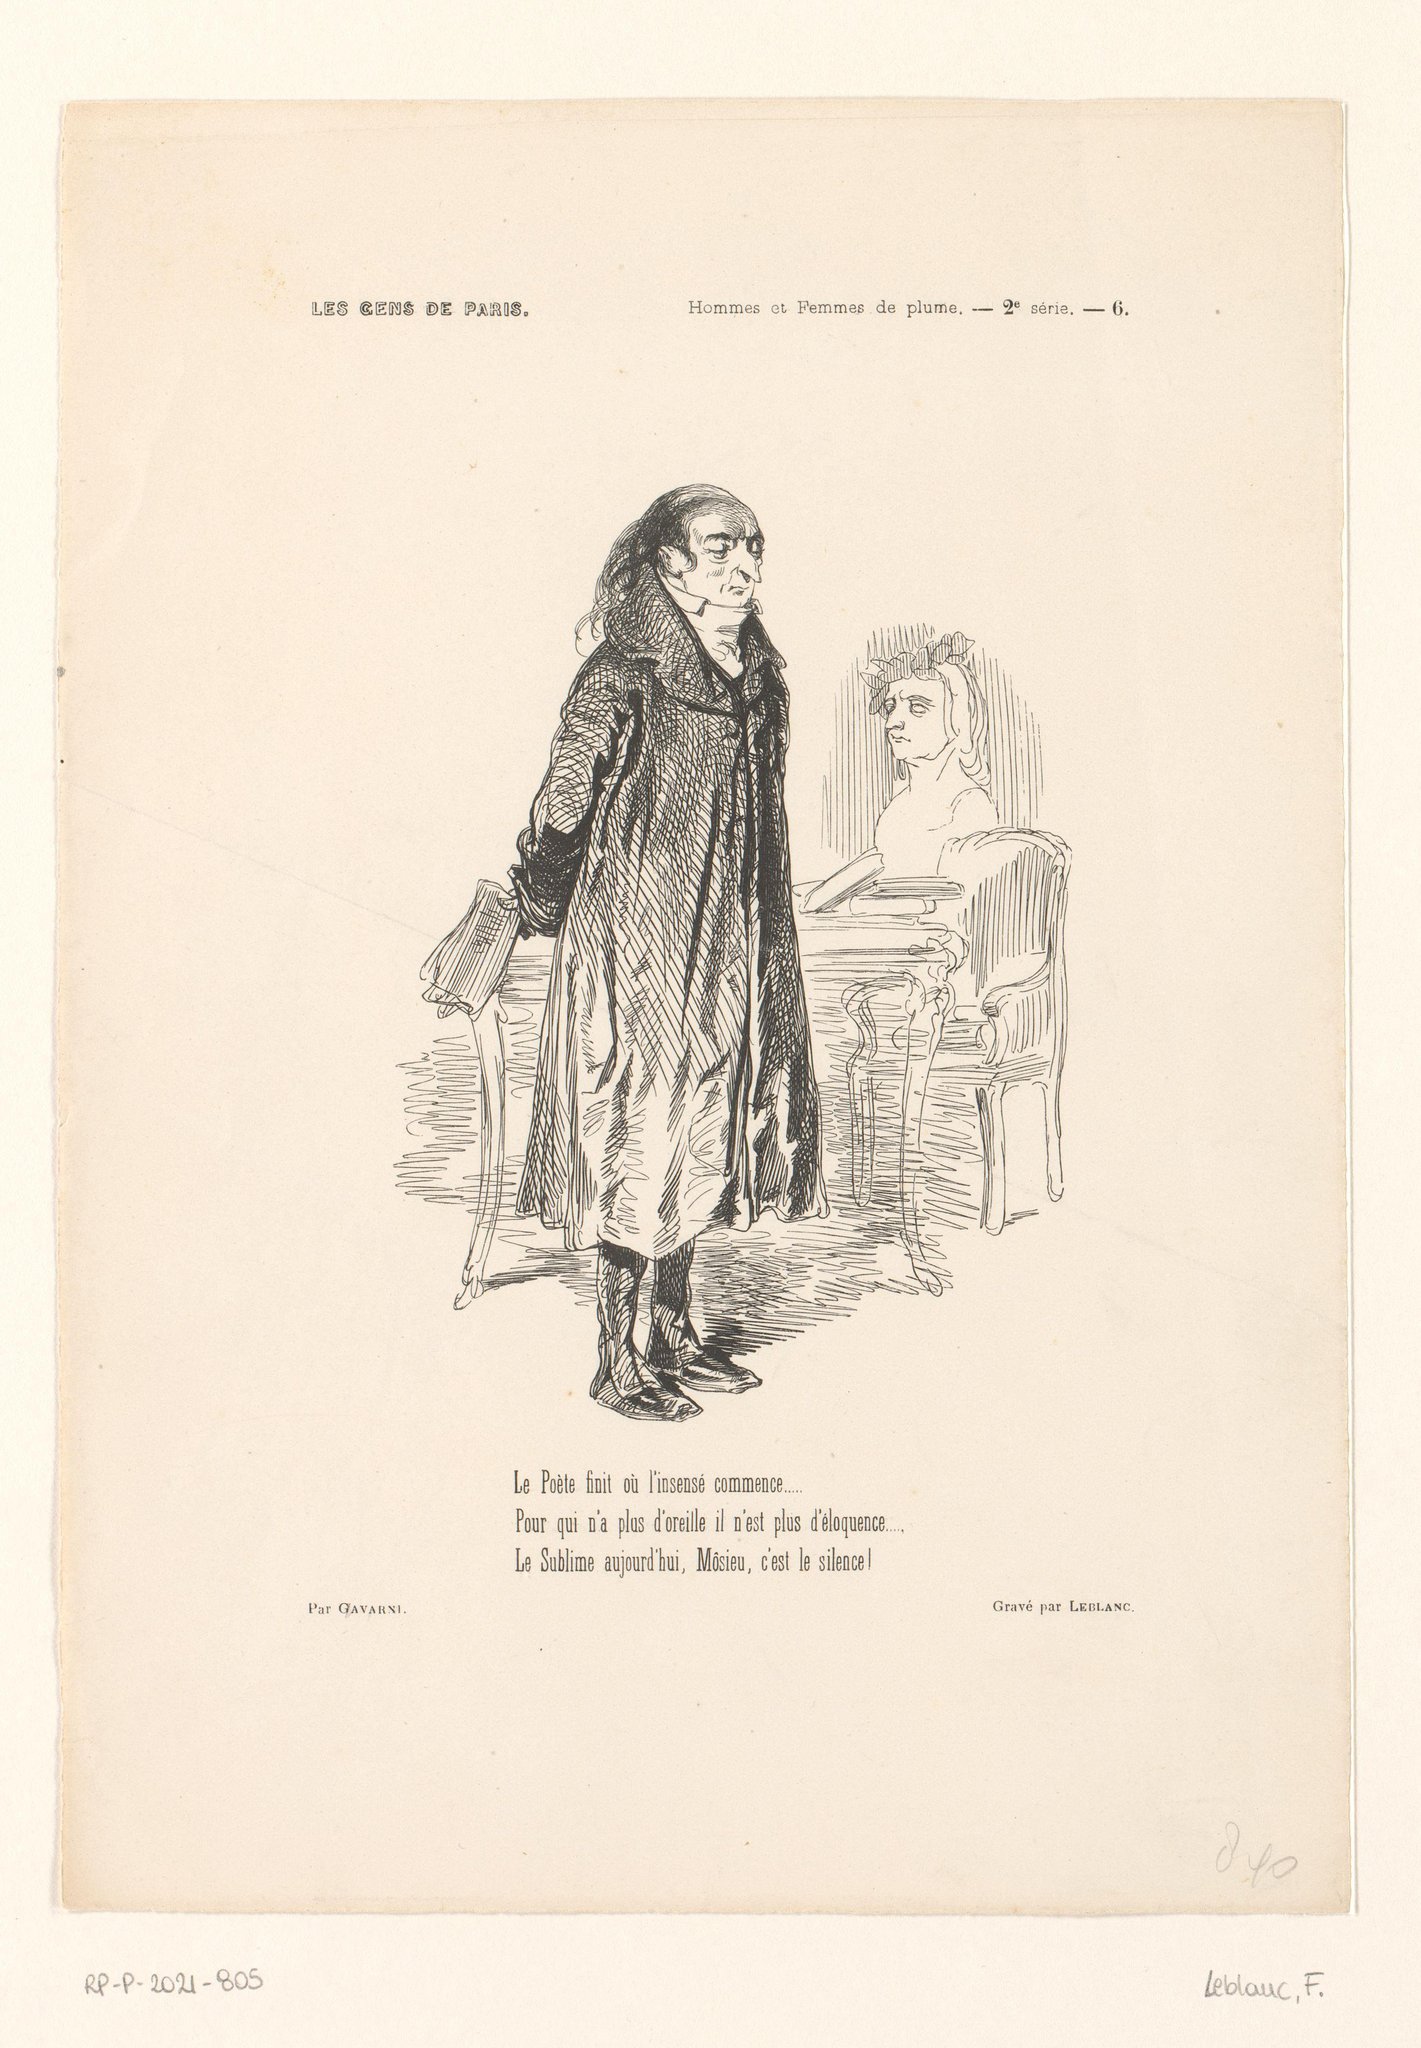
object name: print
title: Dichter staat in interieur met papieren in zijn hand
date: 1846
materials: paper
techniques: letterpress printing, engraving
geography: france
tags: book, writer, poet, author, paper (writing material), fame ~ writer, 'poeta laureatus', paris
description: Prent waarschijnlijk uit: Sand, George. Le diable à Paris: Paris et les Parisiens (...). Parijs: J. Hetzel, 1846.